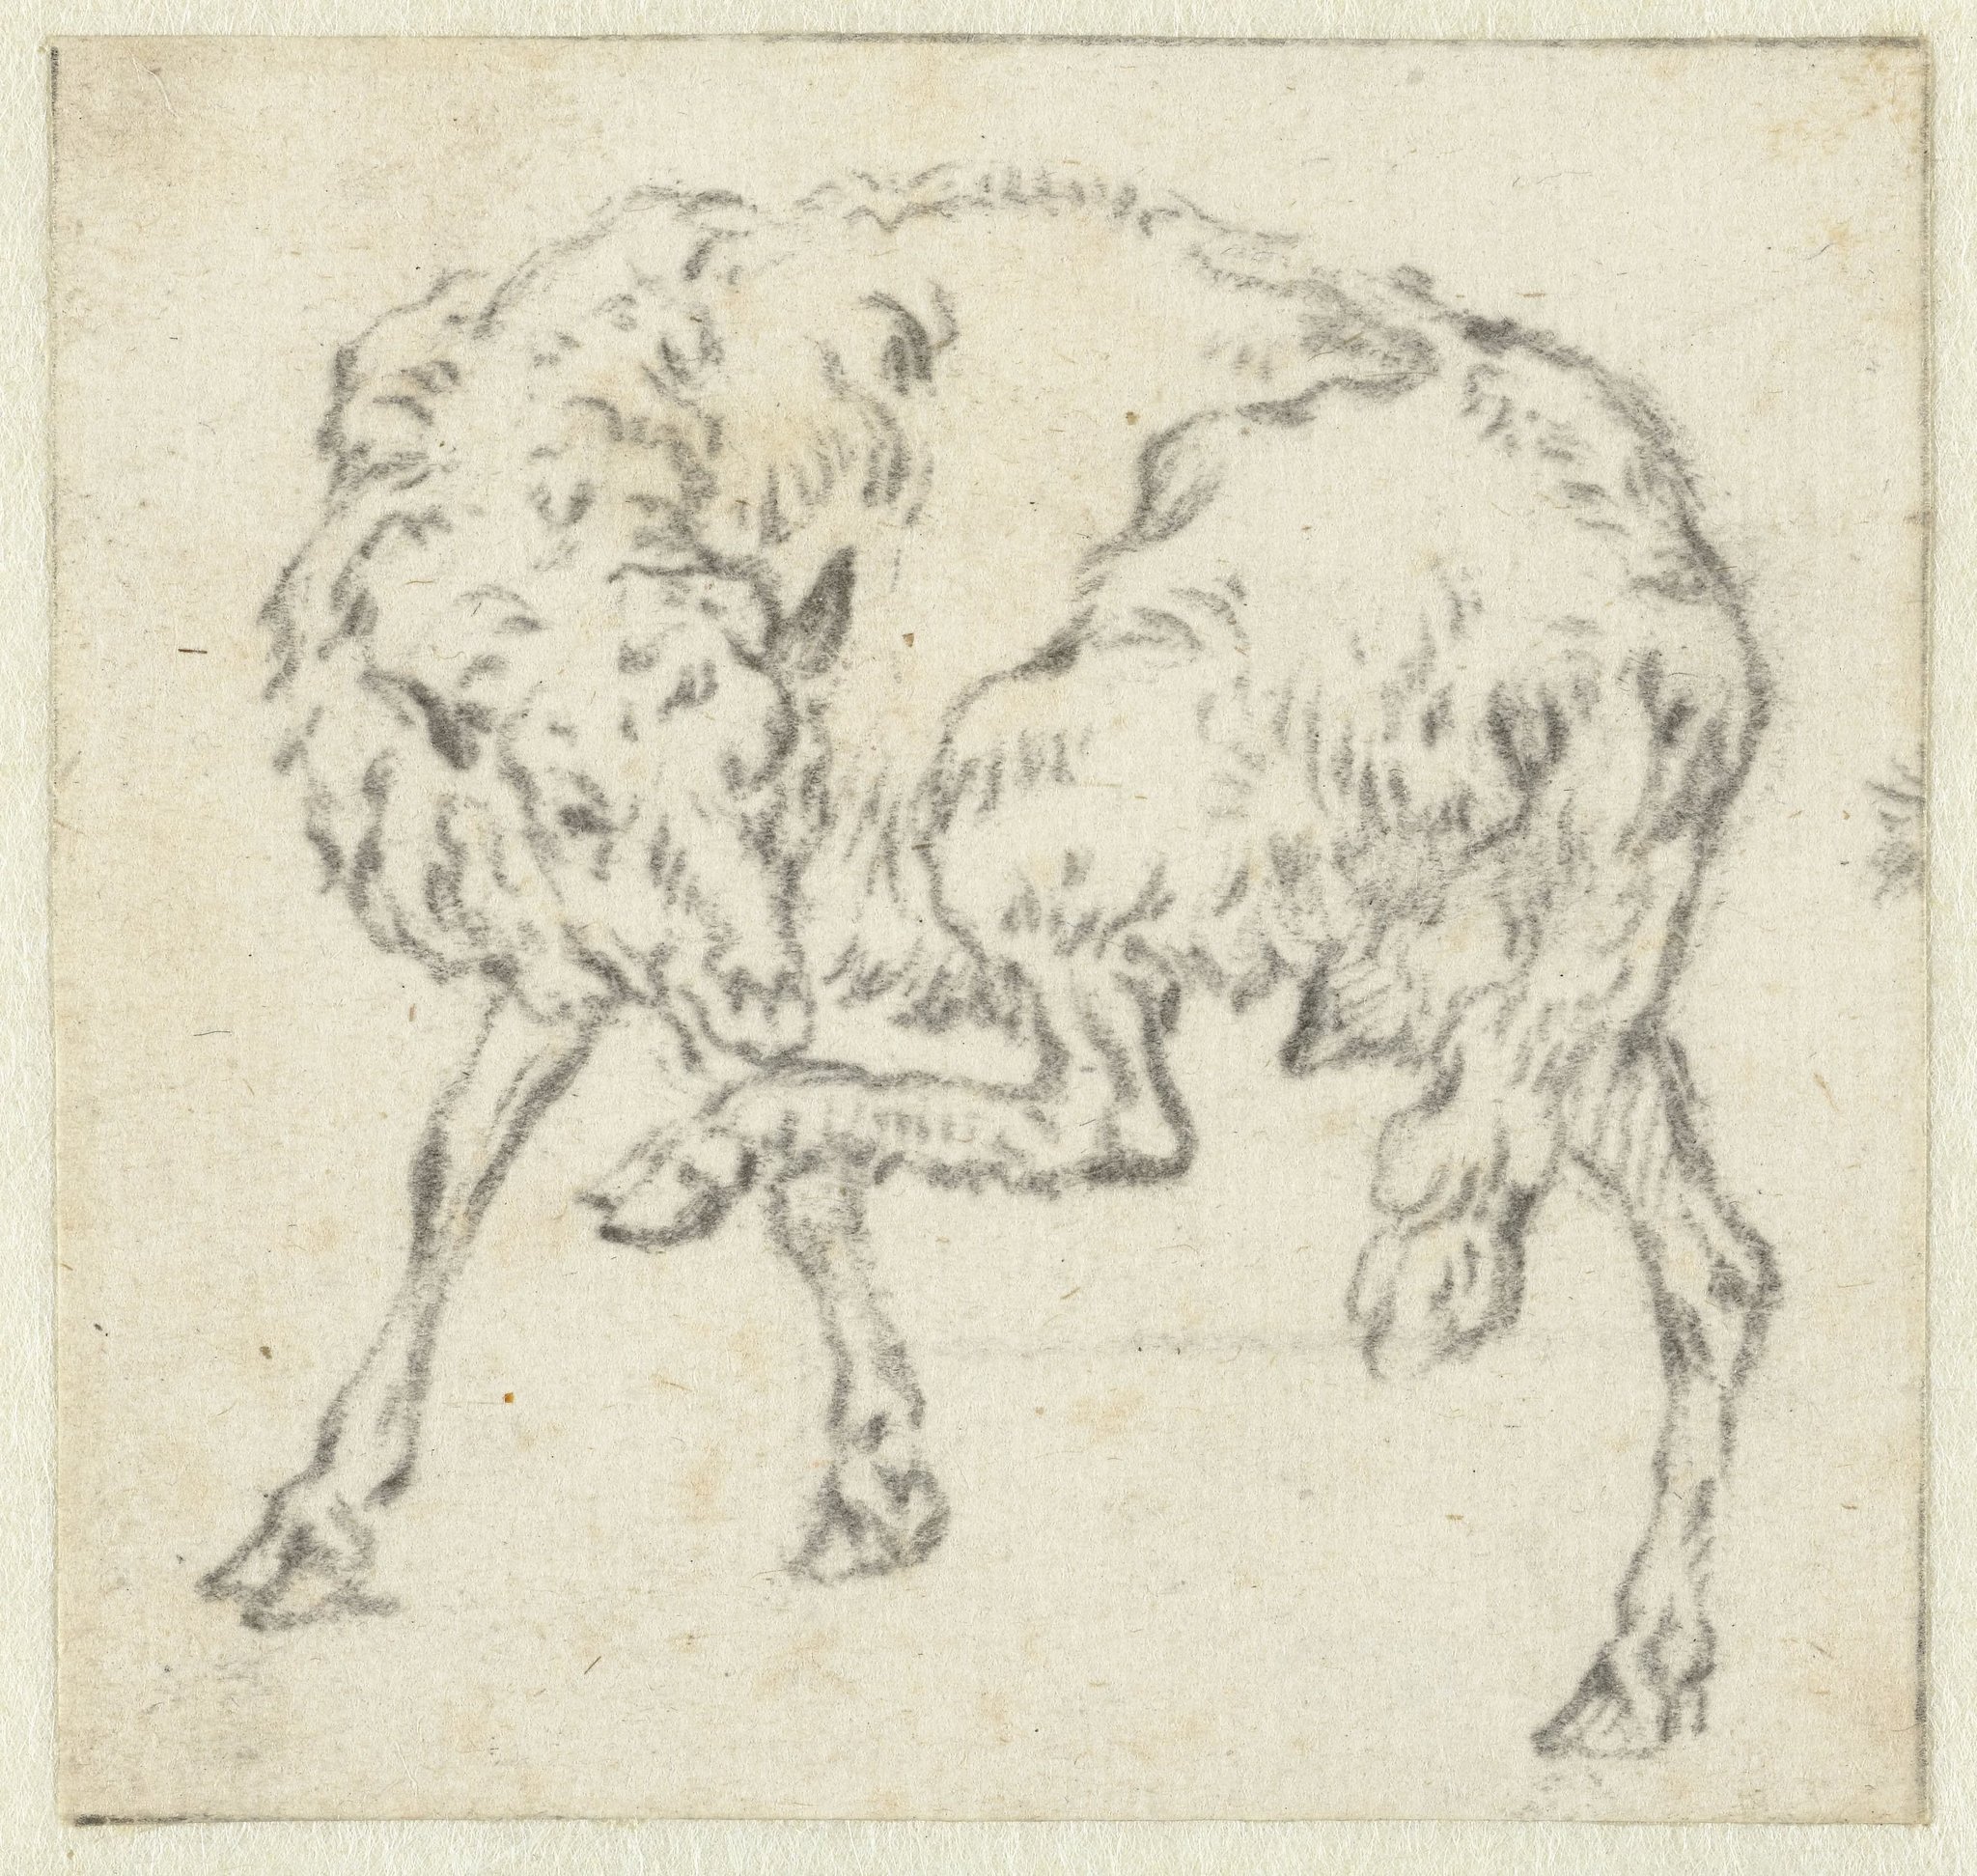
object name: drawing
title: Sheep, Lifting its Left Hind Leg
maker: Anonymous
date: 1670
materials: chalk, paper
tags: sheep